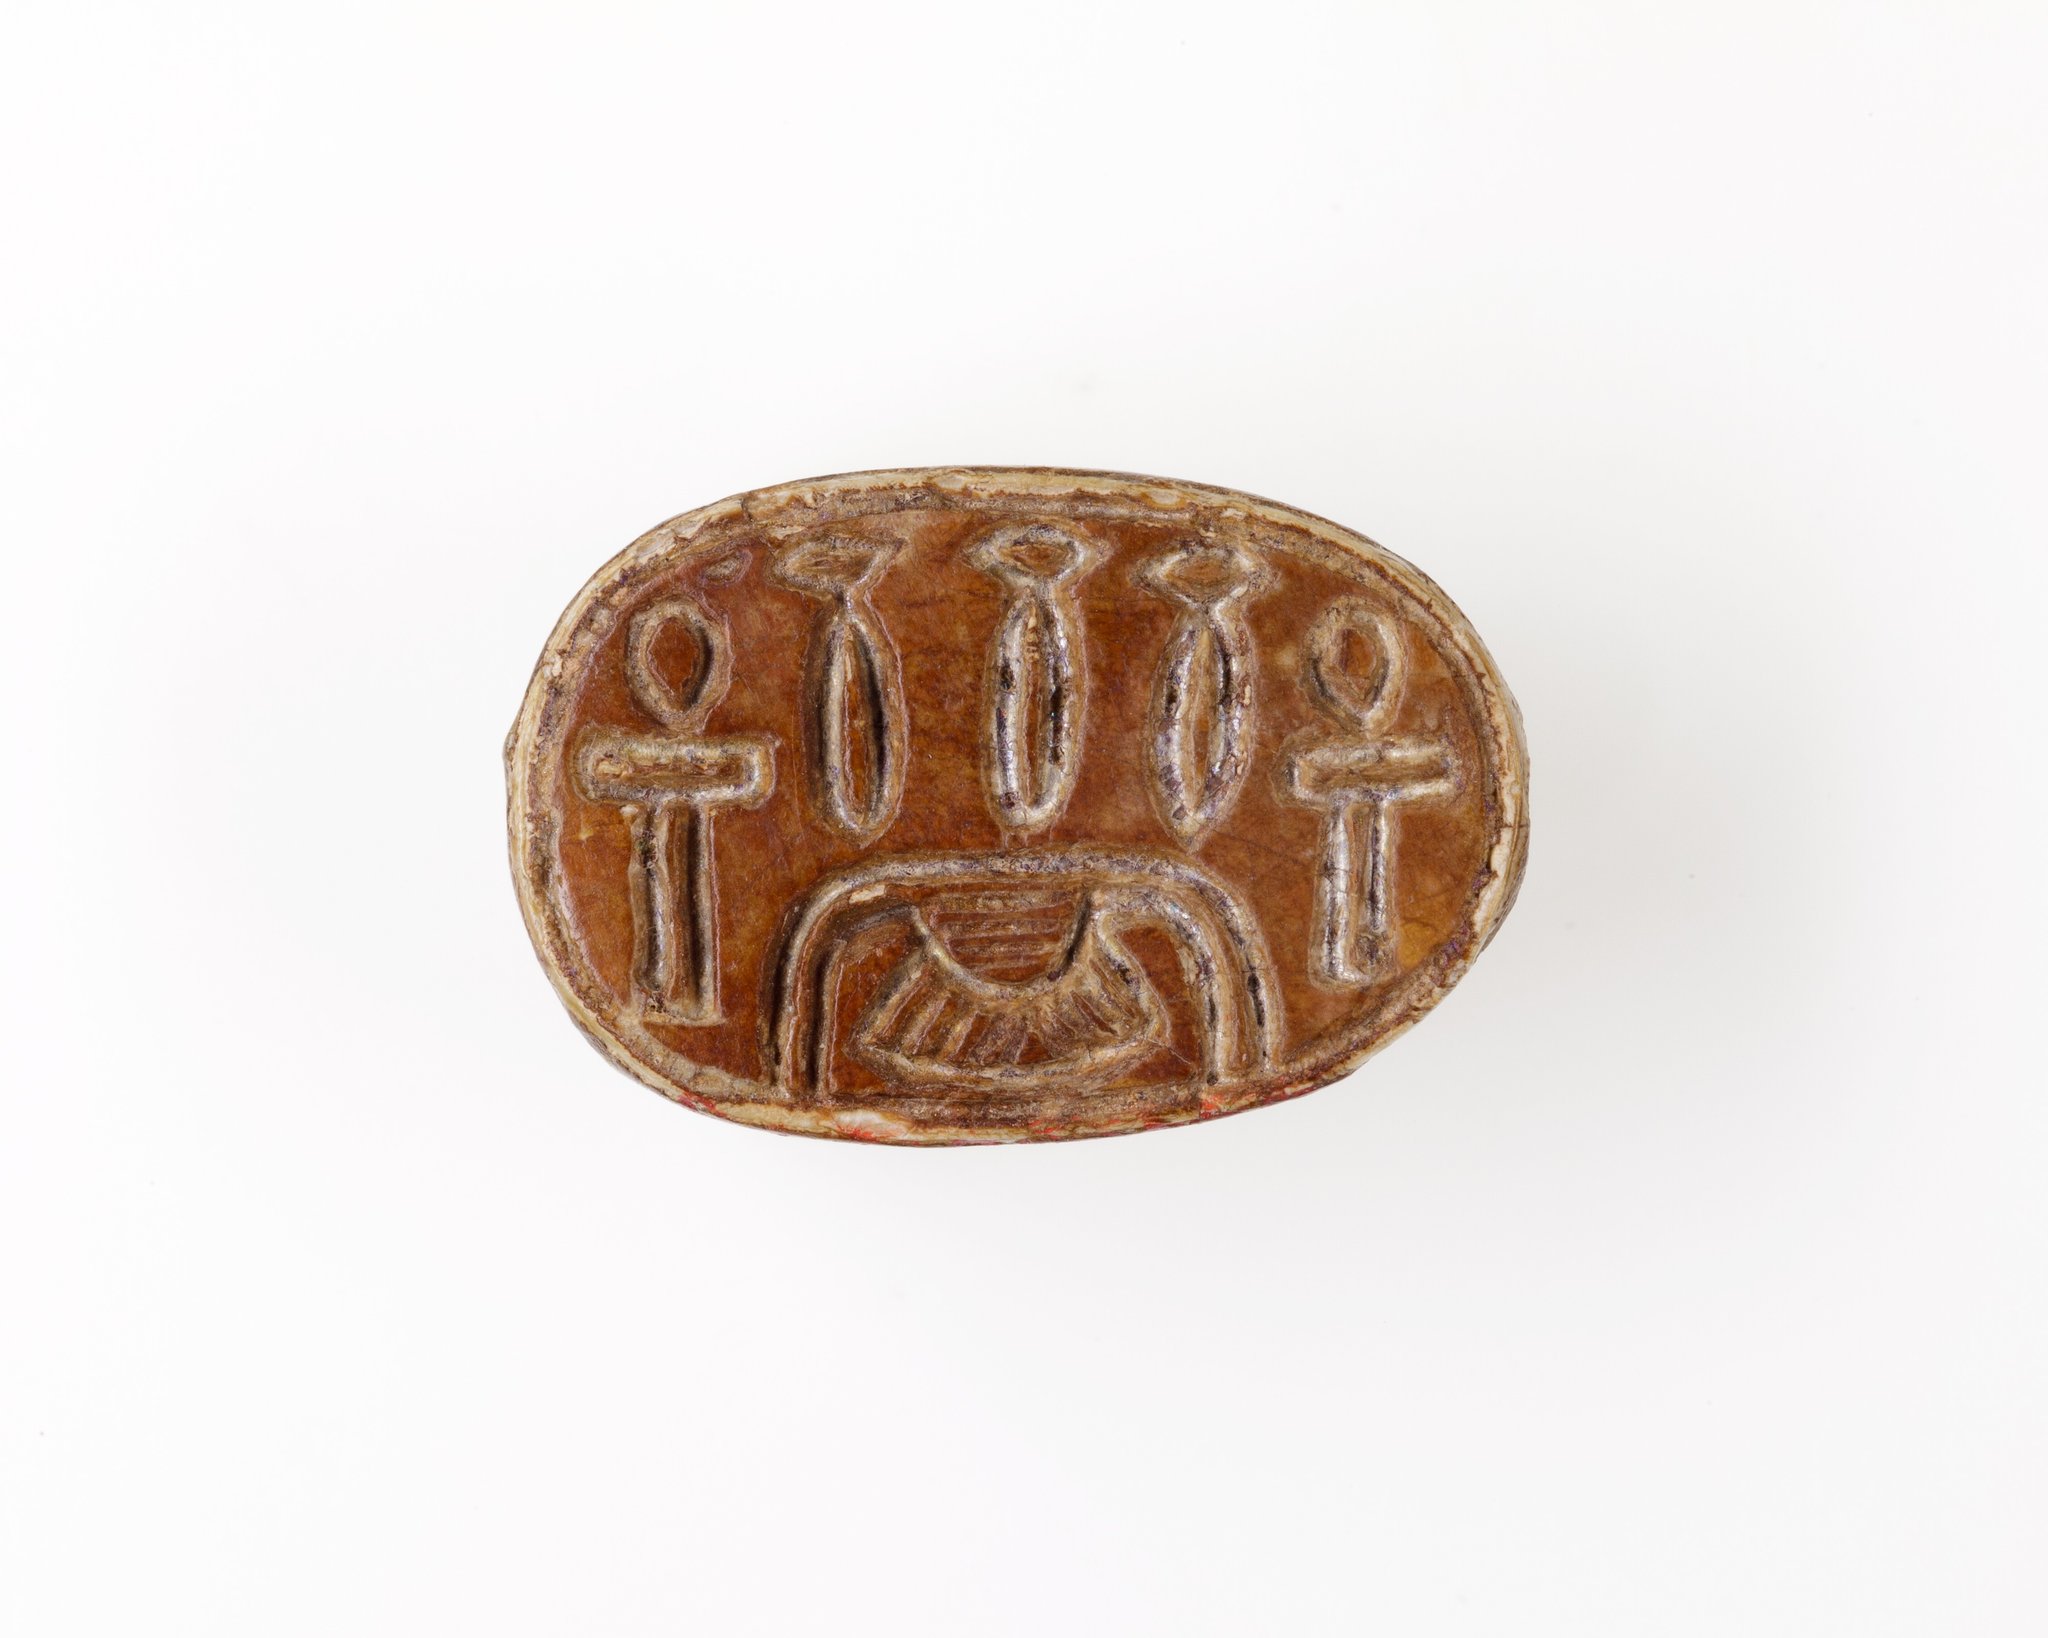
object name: scarab, hieroglyph, nub sign, wadj, ankh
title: Scarab Inscribed with Hieroglyphs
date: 1850-1640 BCE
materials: stone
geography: egypt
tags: scarabs